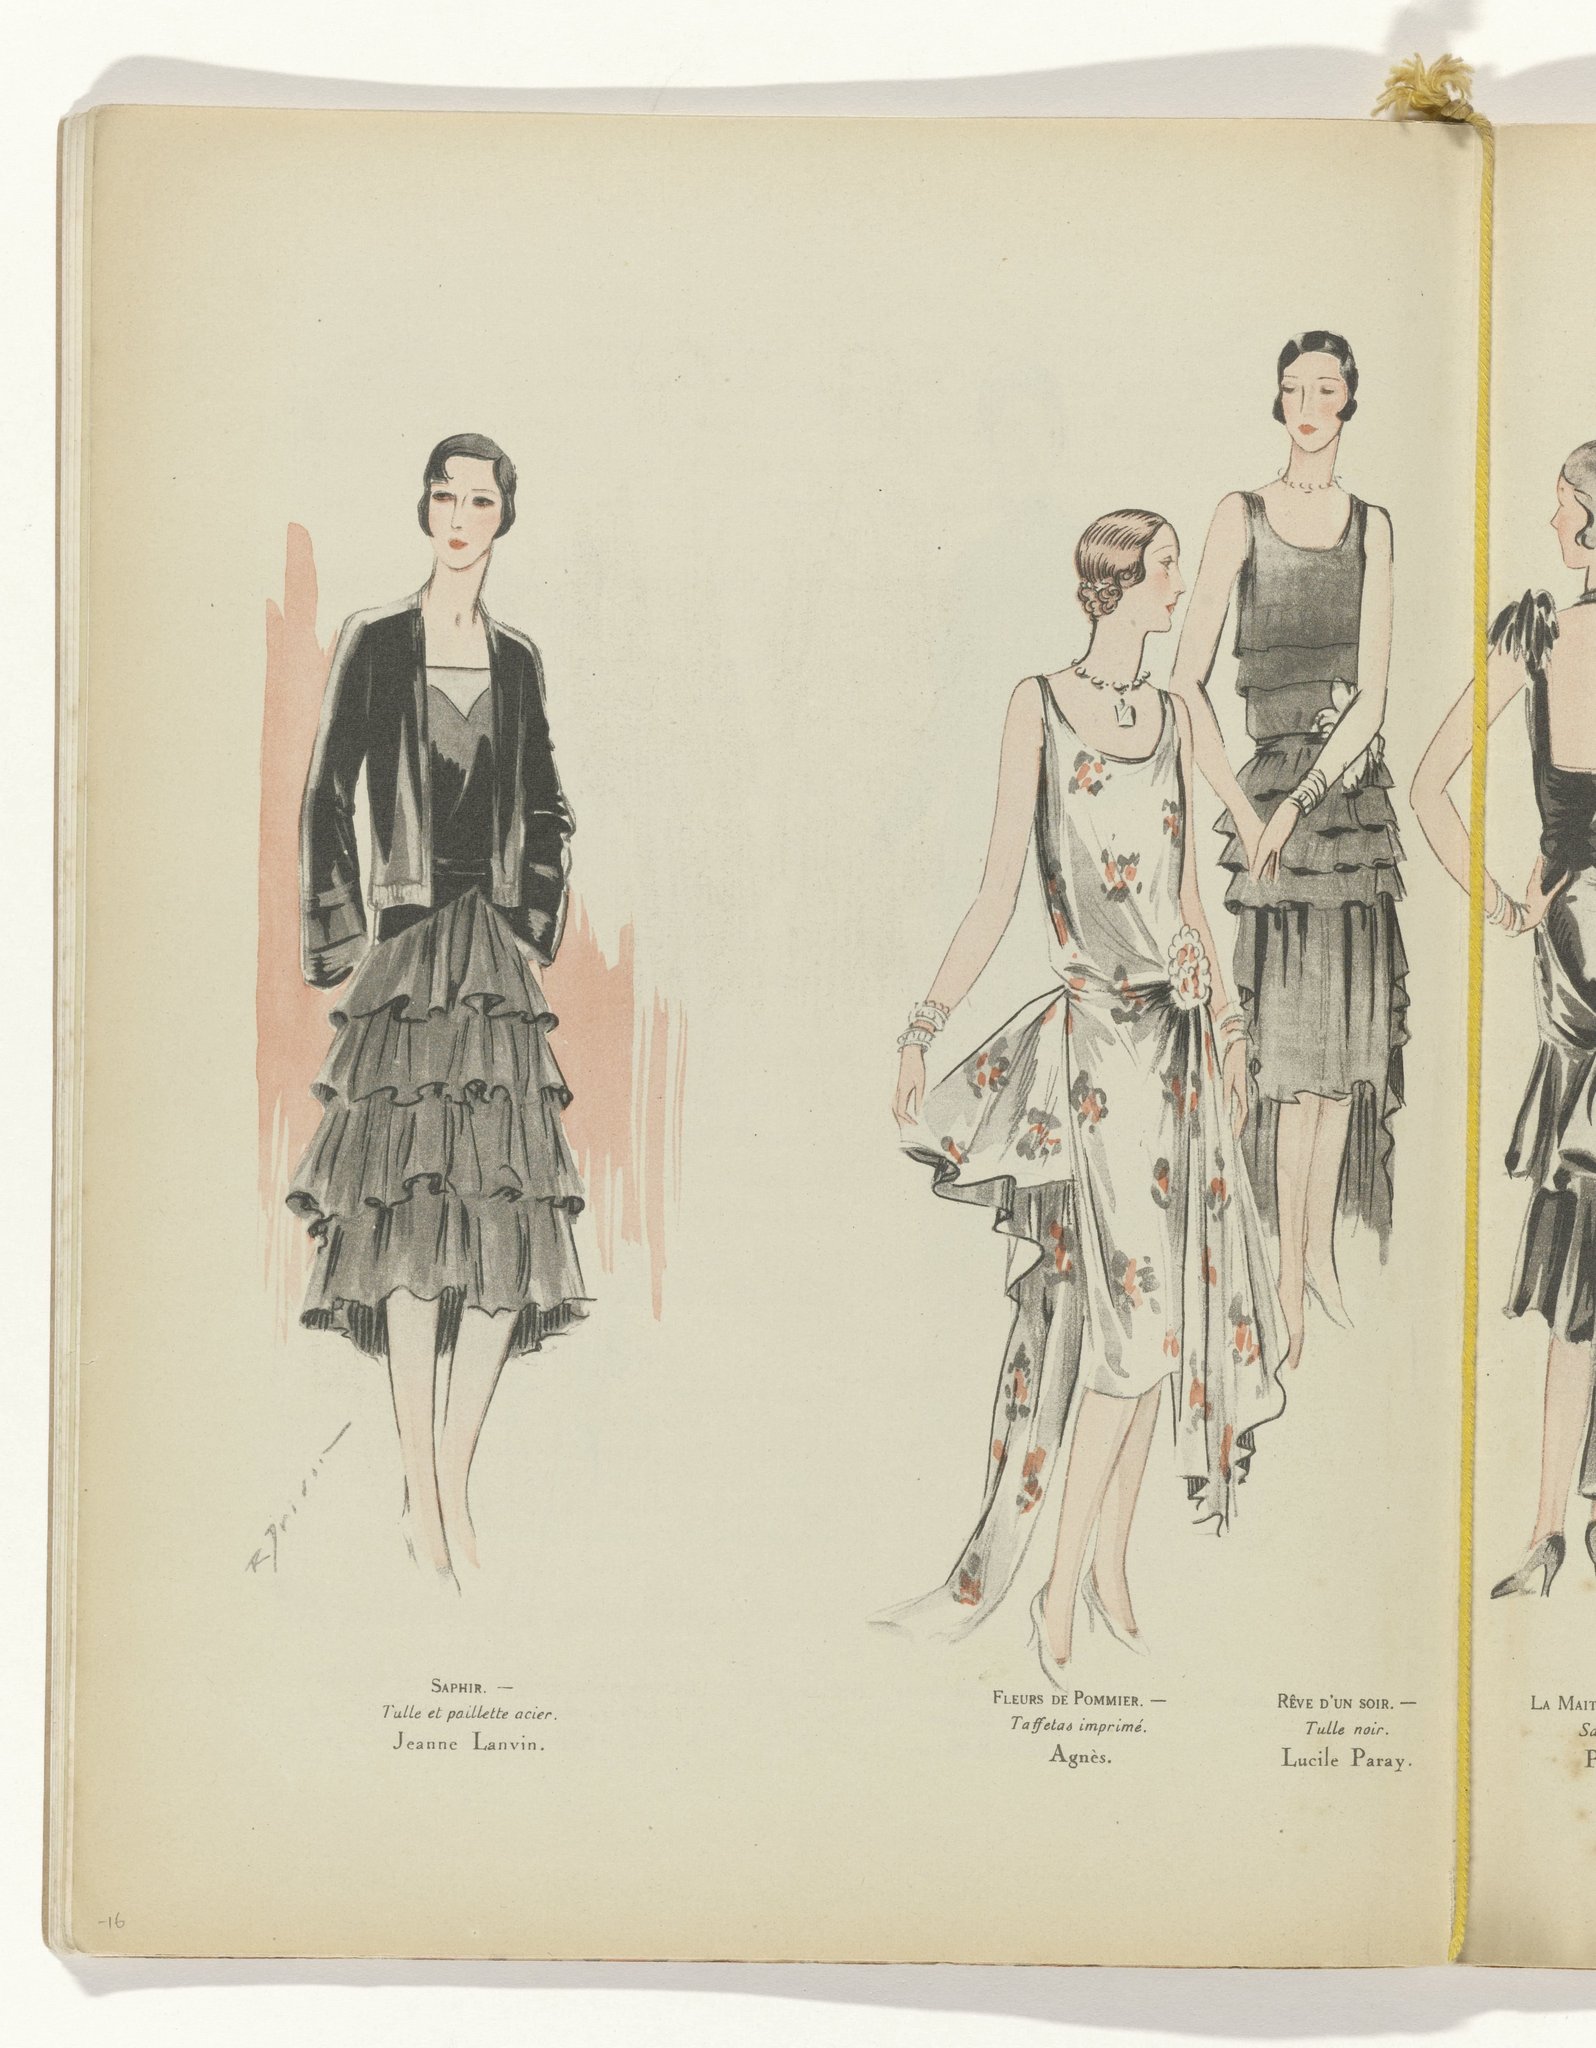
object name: magazine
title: Art - Goût - Beauté, Feuillets de l' élégance féminine, Mai 1929, No. 105, 9e Année, p. 16 en 17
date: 1929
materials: paper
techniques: printing, photography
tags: fashion plates, dress, gown (+ women's clothes)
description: Japonnen van verschillende modehuizen. Van links naar rechts: Jeanne Lanvin, Agnès, Lucille Paray. Pagina uit het modetijdschrift Art-Goût-Beauté (1920-1933).